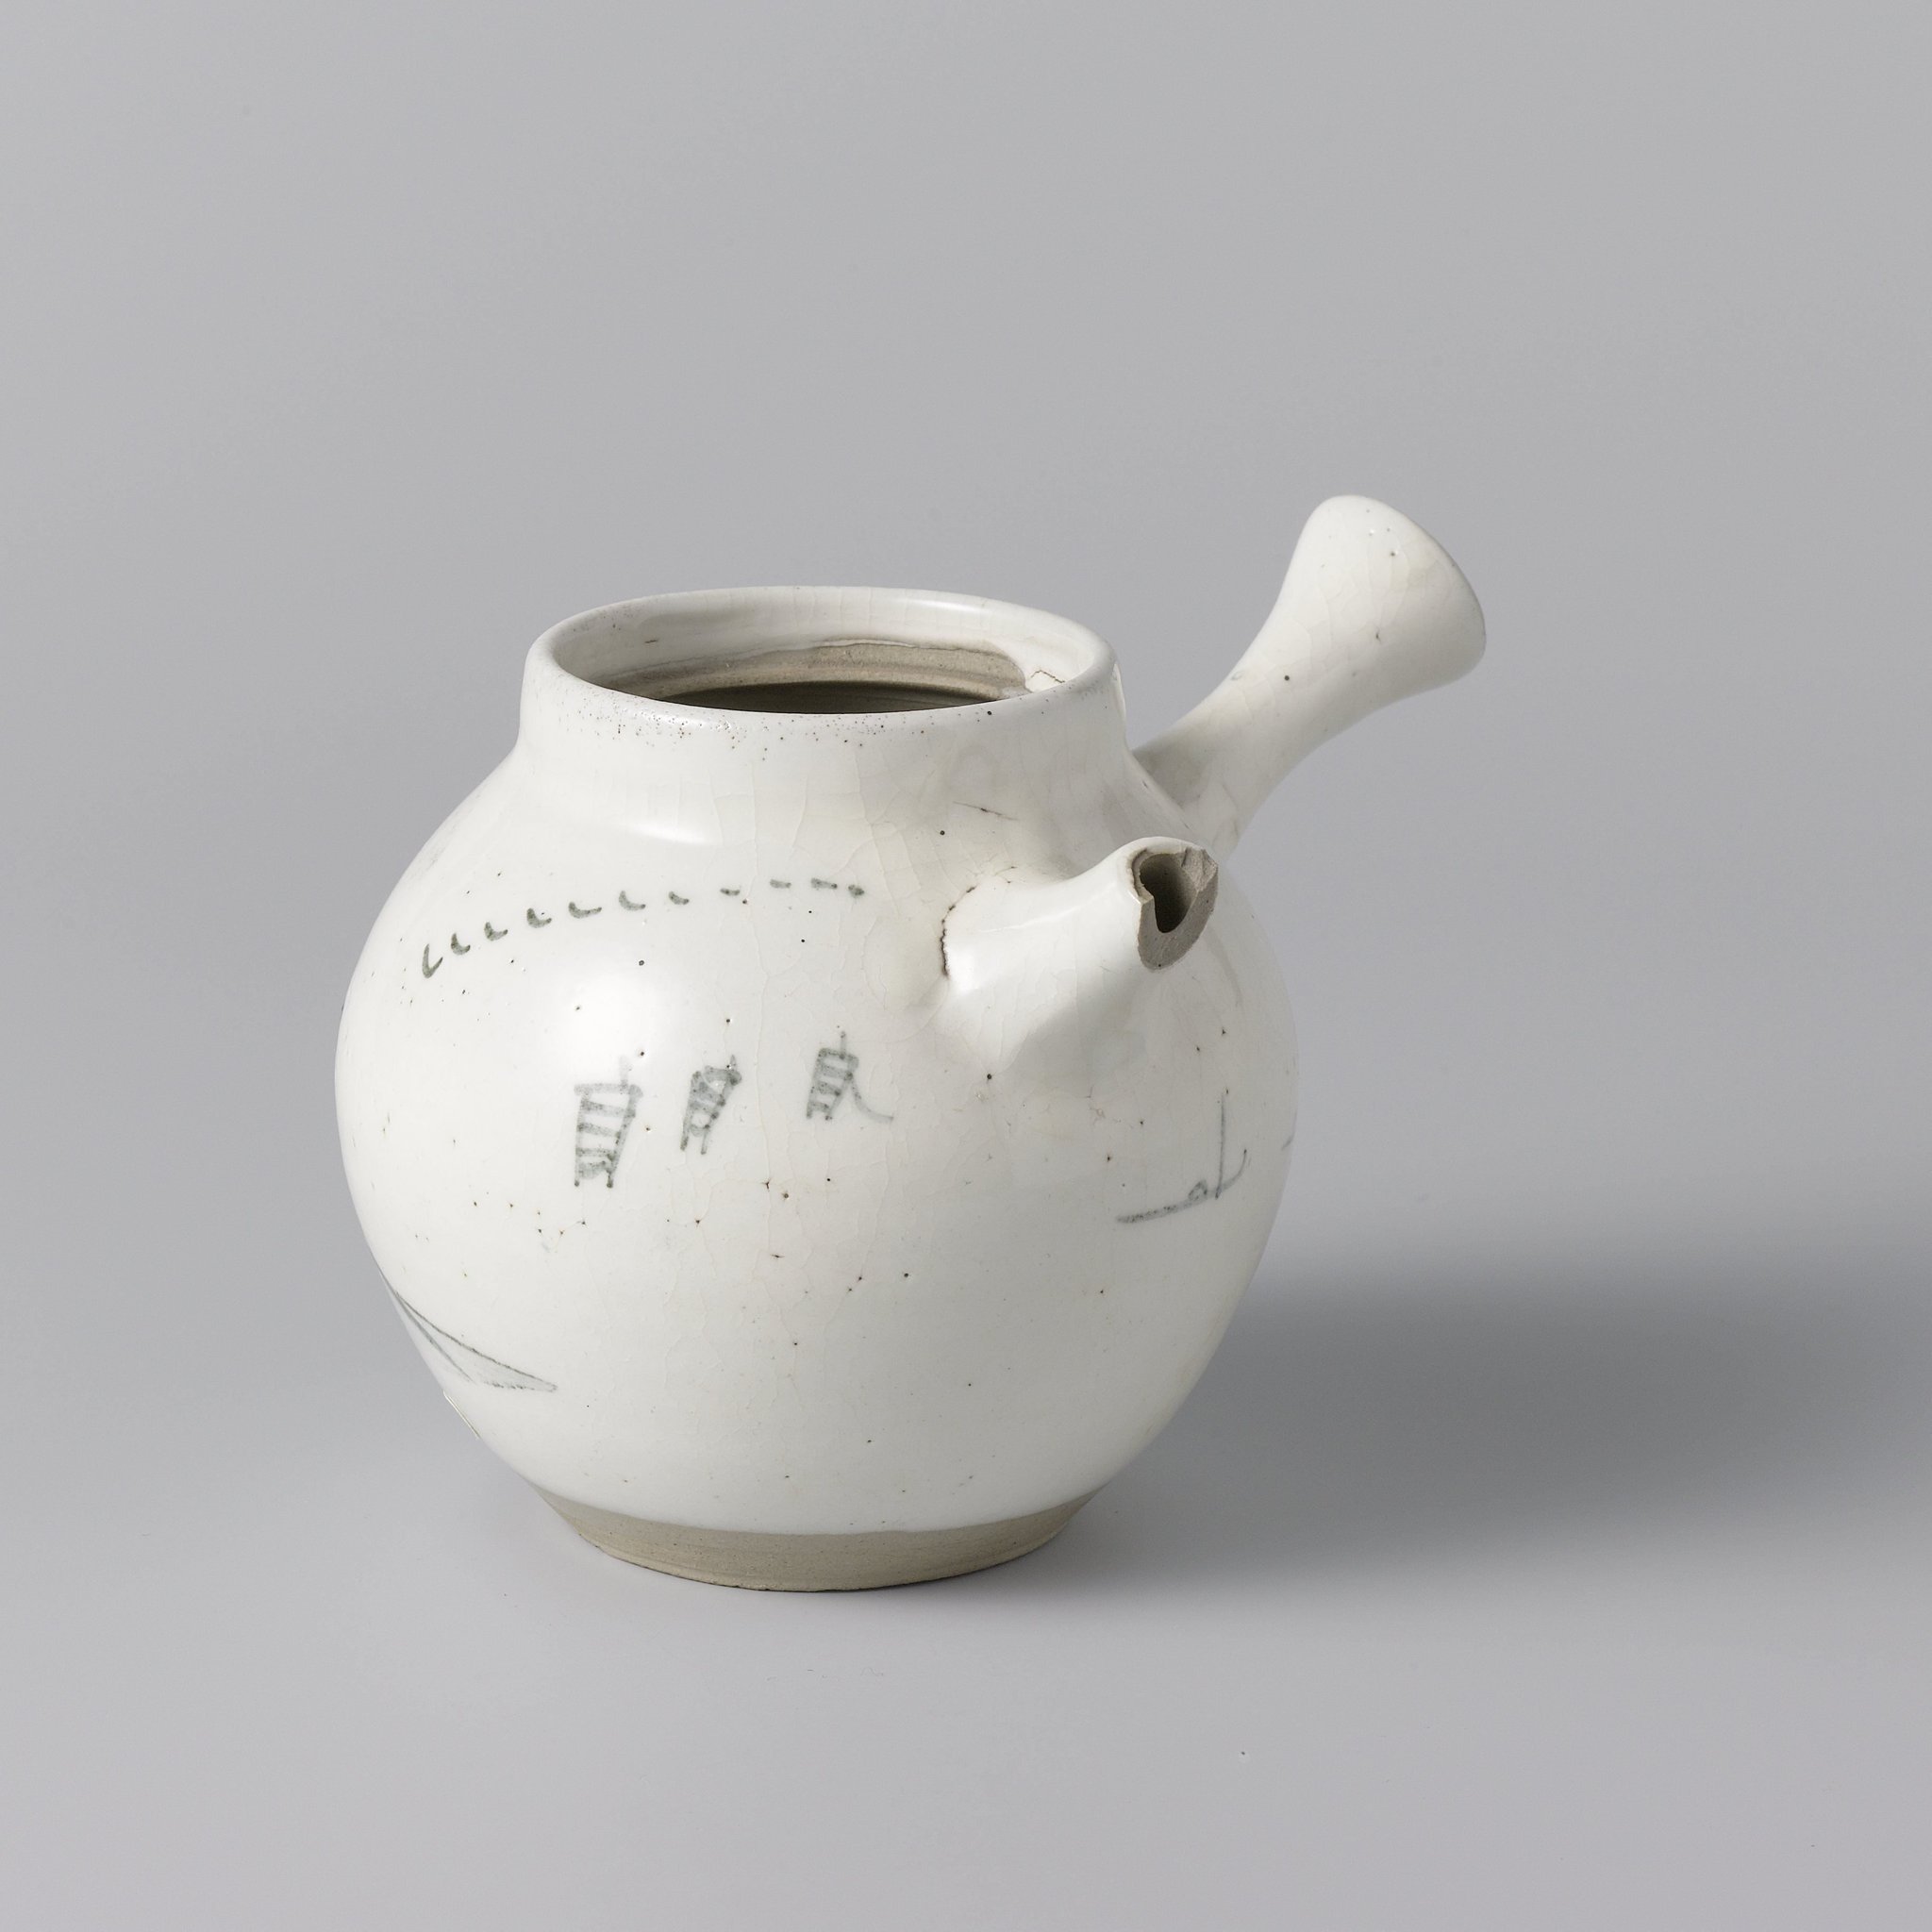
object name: teapot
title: Teapot with trees and a pavilion in a mountainous landscape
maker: Anonymous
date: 1800-1850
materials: cobalt, glaze, paint, stoneware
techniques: firing, turning, vitrification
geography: japan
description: Theepot van steengoed met een rechte ruit en steelvormig oor, bedekt met een wit slib en beschilderd in onderglazuur blauw. Op de wand een berglandschap met bomen, een paviljoen, vogels en twee boten. Het oor zit aan de zijkant van de pot. De onderzijde is ongeglazuurd. Tuit is gedeeltelijk afgebroken. Blauw-wit.